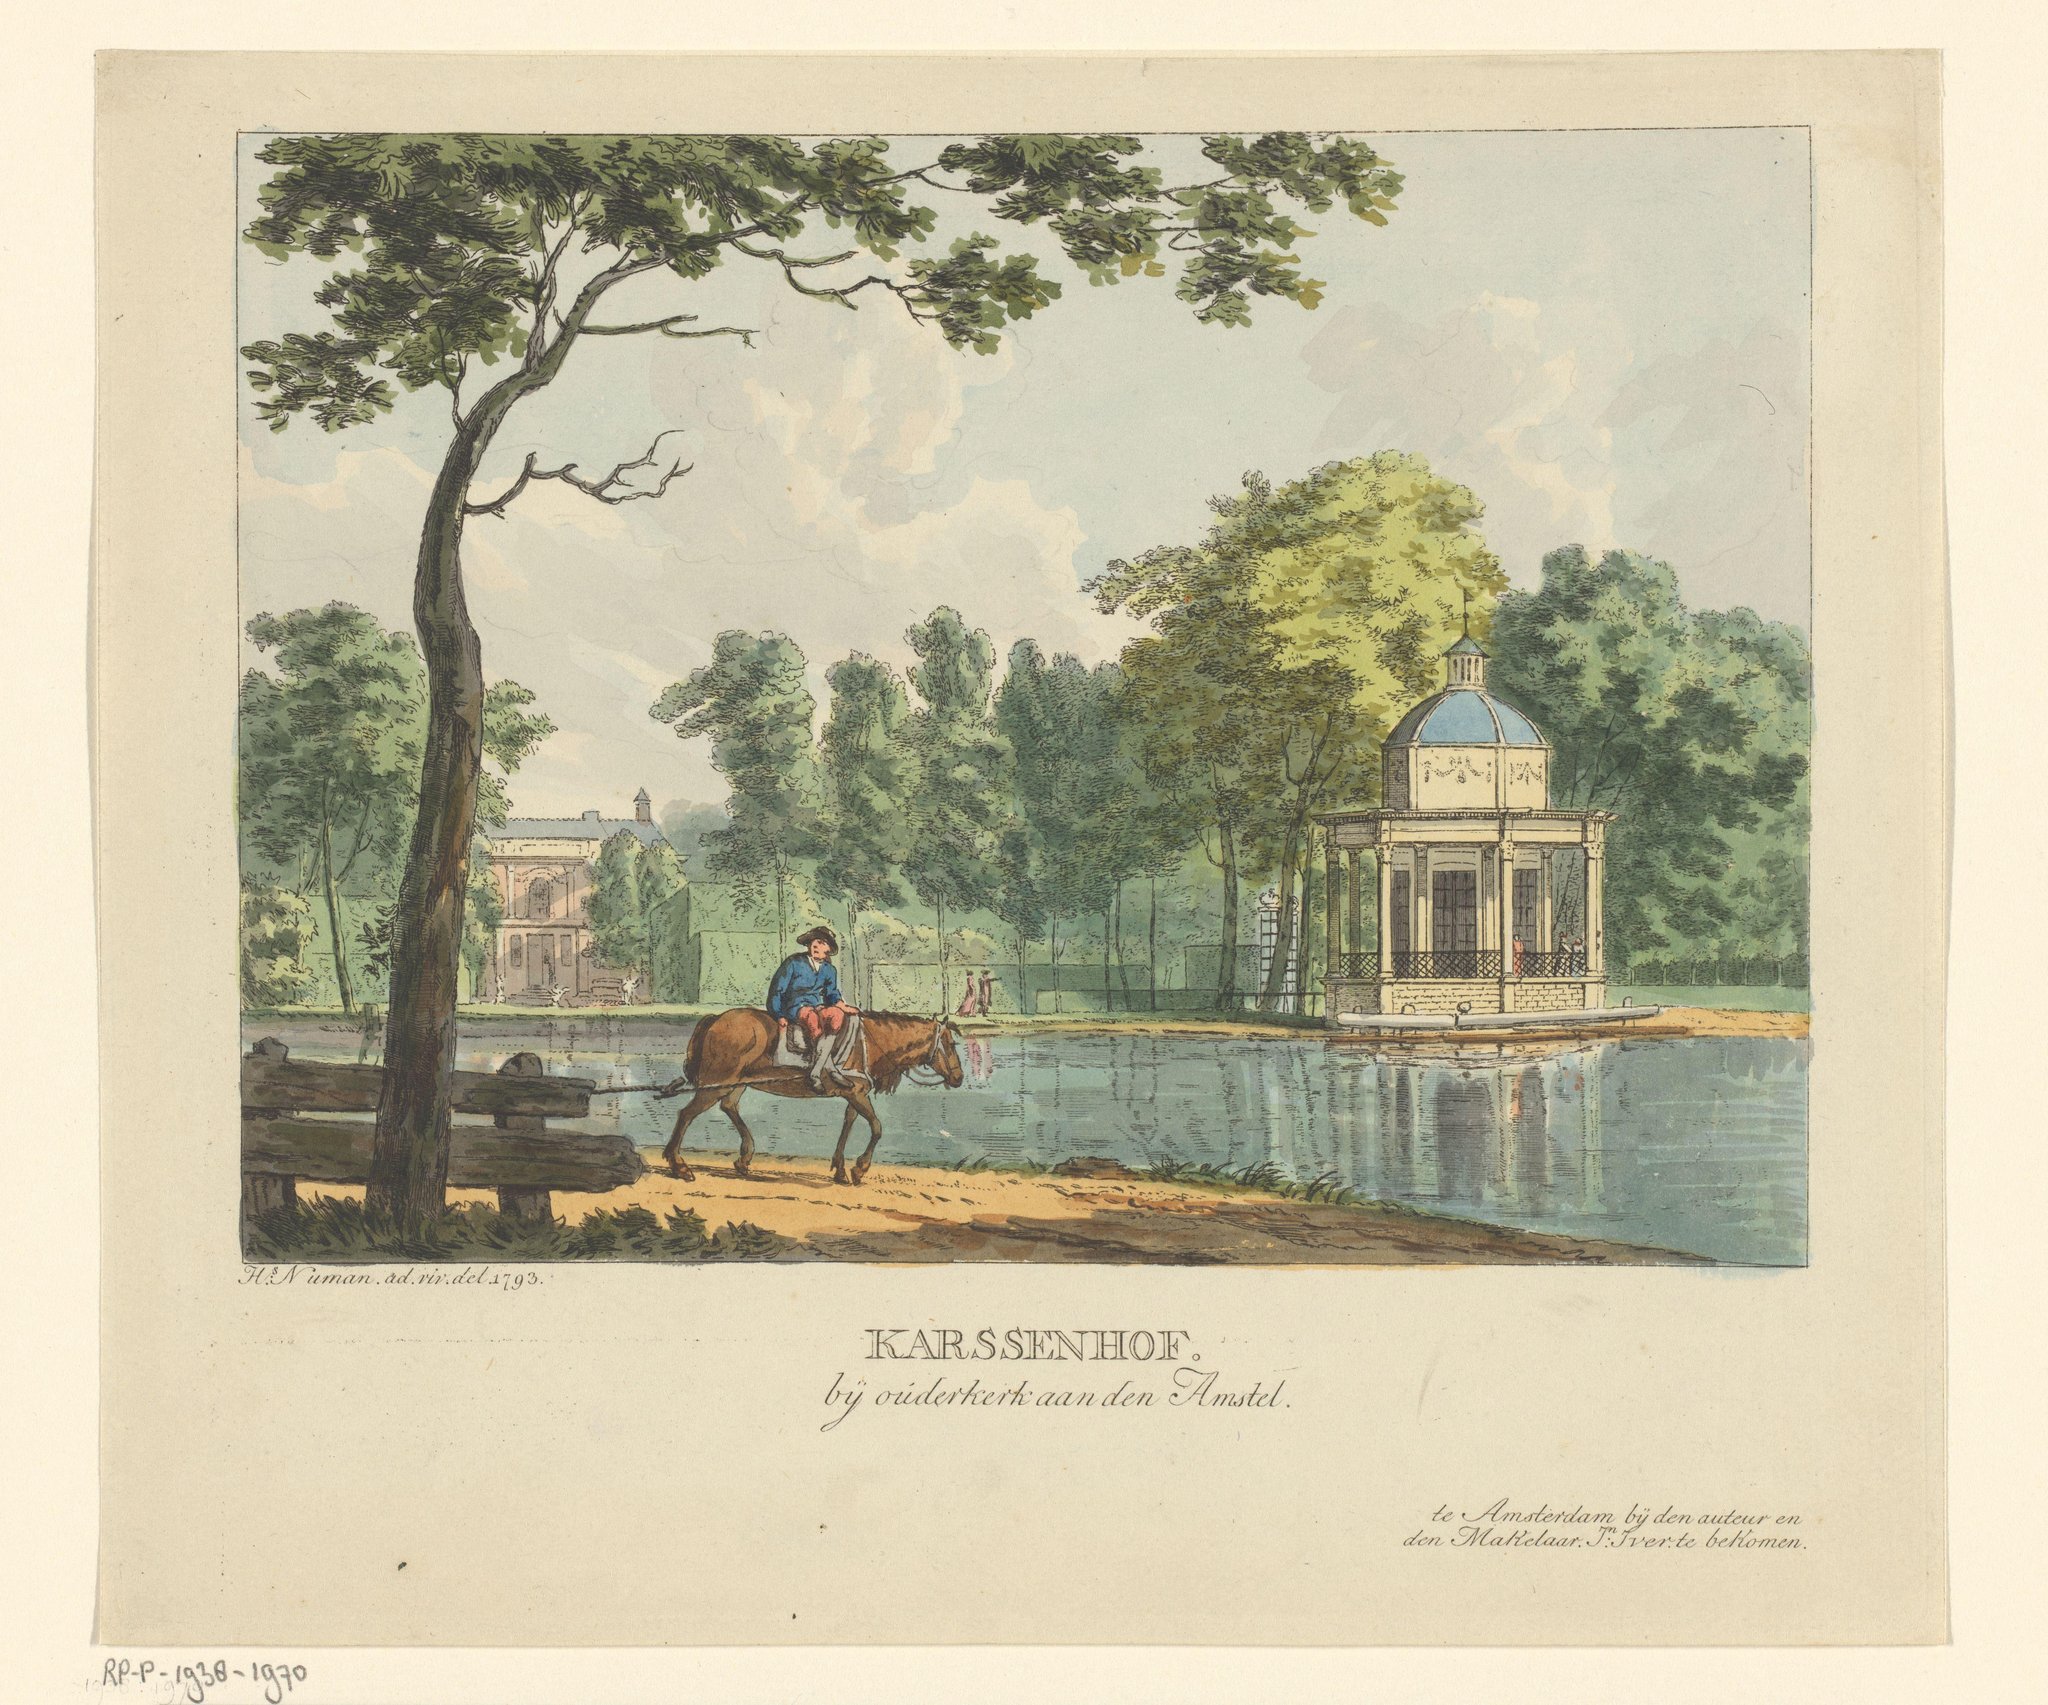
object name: print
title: Buitenplaats Karssenhof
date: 1793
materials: paper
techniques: etching, hand coloring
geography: amsterdam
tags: country-house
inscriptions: collector's mark: Lugt 2228, collector's mark: Lugt 2760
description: Gezicht op het landhuis Karssenhof te Ouderkerk aan de Amstel. Links aan de overzijde van de rivier de Amstel ligt het landhuis. Rechts aan de Amstel een prieel. Op de voorgrond een ruiter.